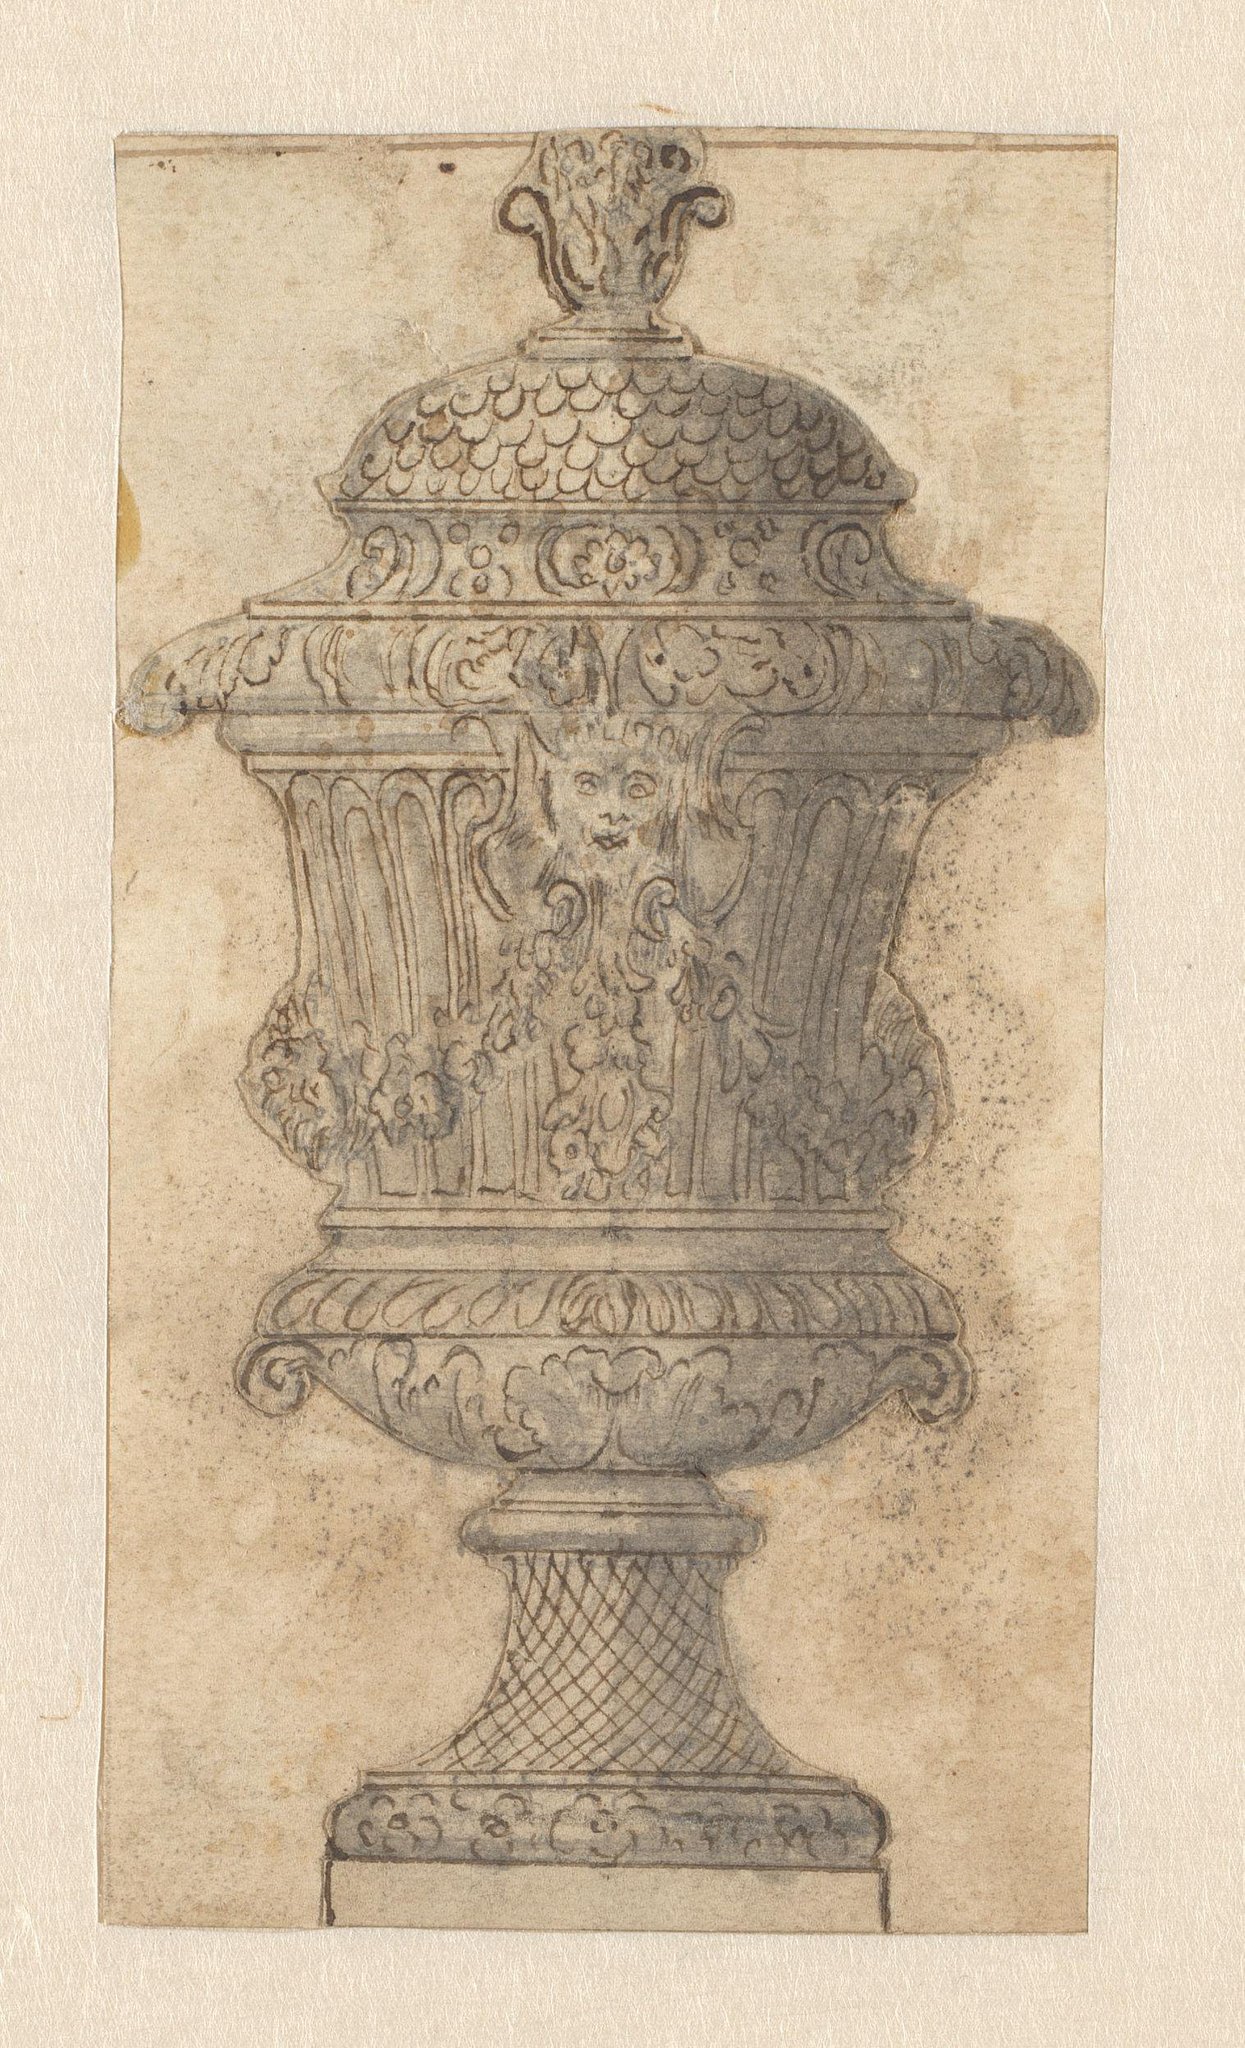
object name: design drawing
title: Ontwerp voor een tuinvaas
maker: Anonymous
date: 1700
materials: ink, paper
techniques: brush, pen, snipping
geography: netherlands